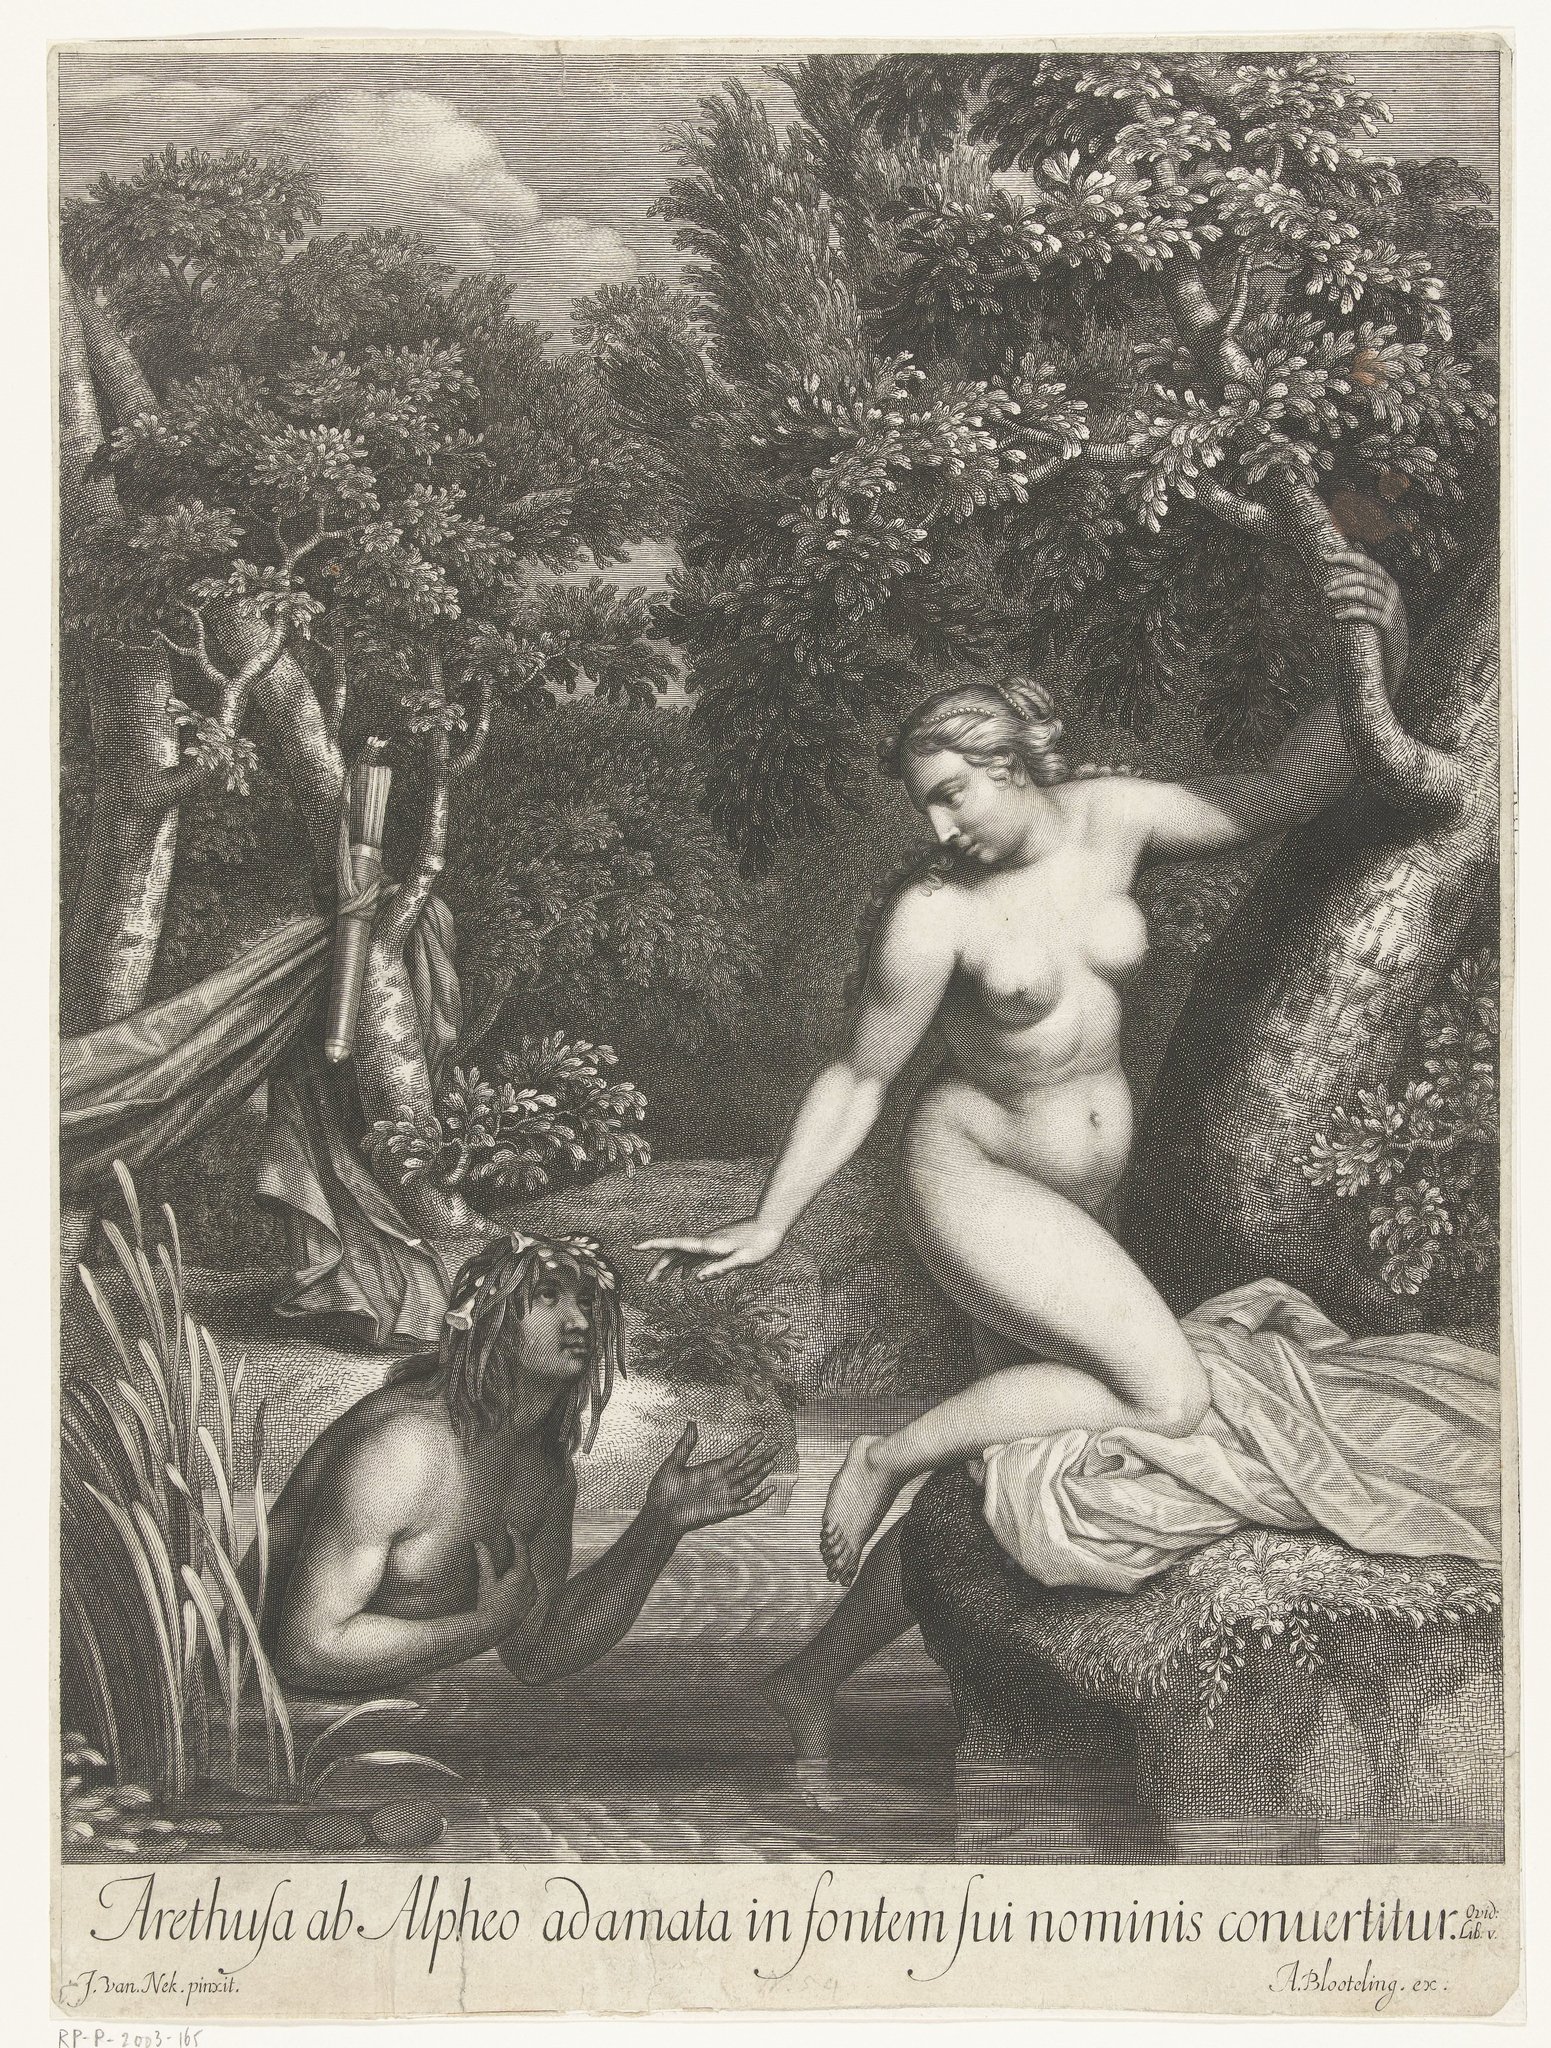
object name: print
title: Alphëus en Arethusa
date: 1655-1690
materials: paper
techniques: engraving, etching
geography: amsterdam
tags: alpheus changed into a river-god: when pining away for the love of arethusa, alpheus the hunter is changed into a river-god (pausanias v 7, 2), other nereids (or sea-nymphs): arethusa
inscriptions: title: ‘Arethusa ab Alpheo...convertitur Ovid. Lib: V’, collector's mark: Lugt 2228, collector's mark: Lugt 2760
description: De nimf Arethusa vlucht voor de riviergod Alphëus uit het water. Aan een tak van een boom die aan de oever staat trekt ze zich omhoog. Op de achtergrond hangt aan een boom een pijlenkoker als symbool van de liefde. Onder de prent een vers uit de Metamorfosen van Ovidius.